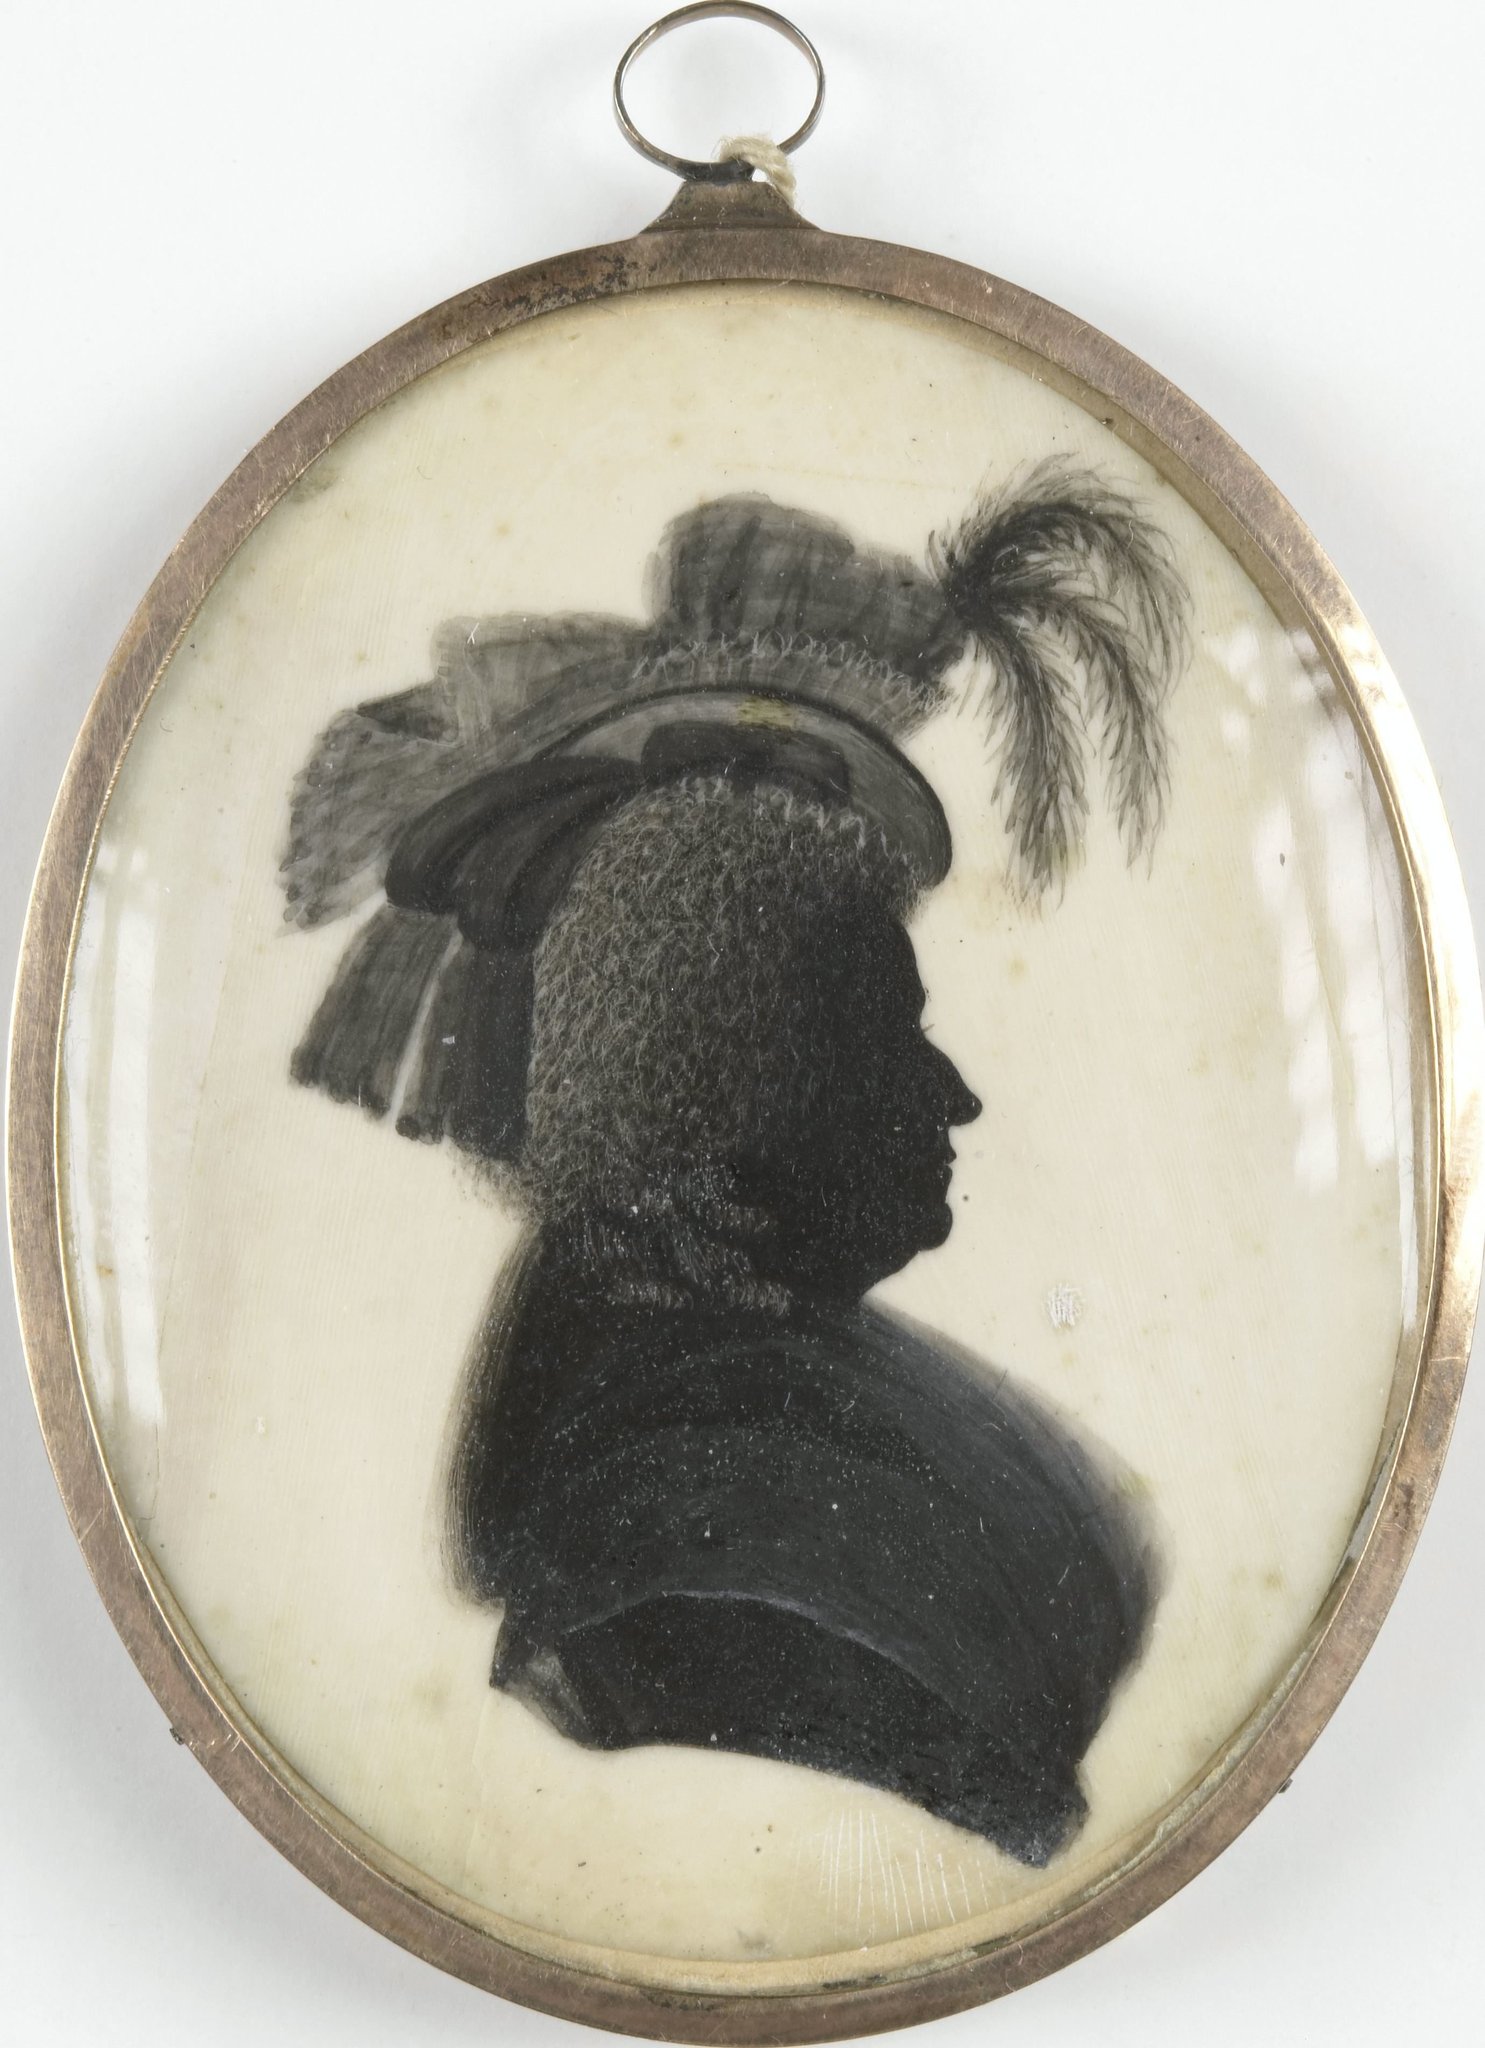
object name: painting, miniature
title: Portret van een vrouw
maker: Anonymous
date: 1790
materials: glass, ivory, metal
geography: northern netherlands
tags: historical persons not known by name - bb - woman (+ profile portrait)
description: Silhouet portret van een Surinaamse (?) vrouw. Buste, naar rechts, op het hoofd een hoed met drie pluimen. Onderdeel van de collectie portretminiaturen.